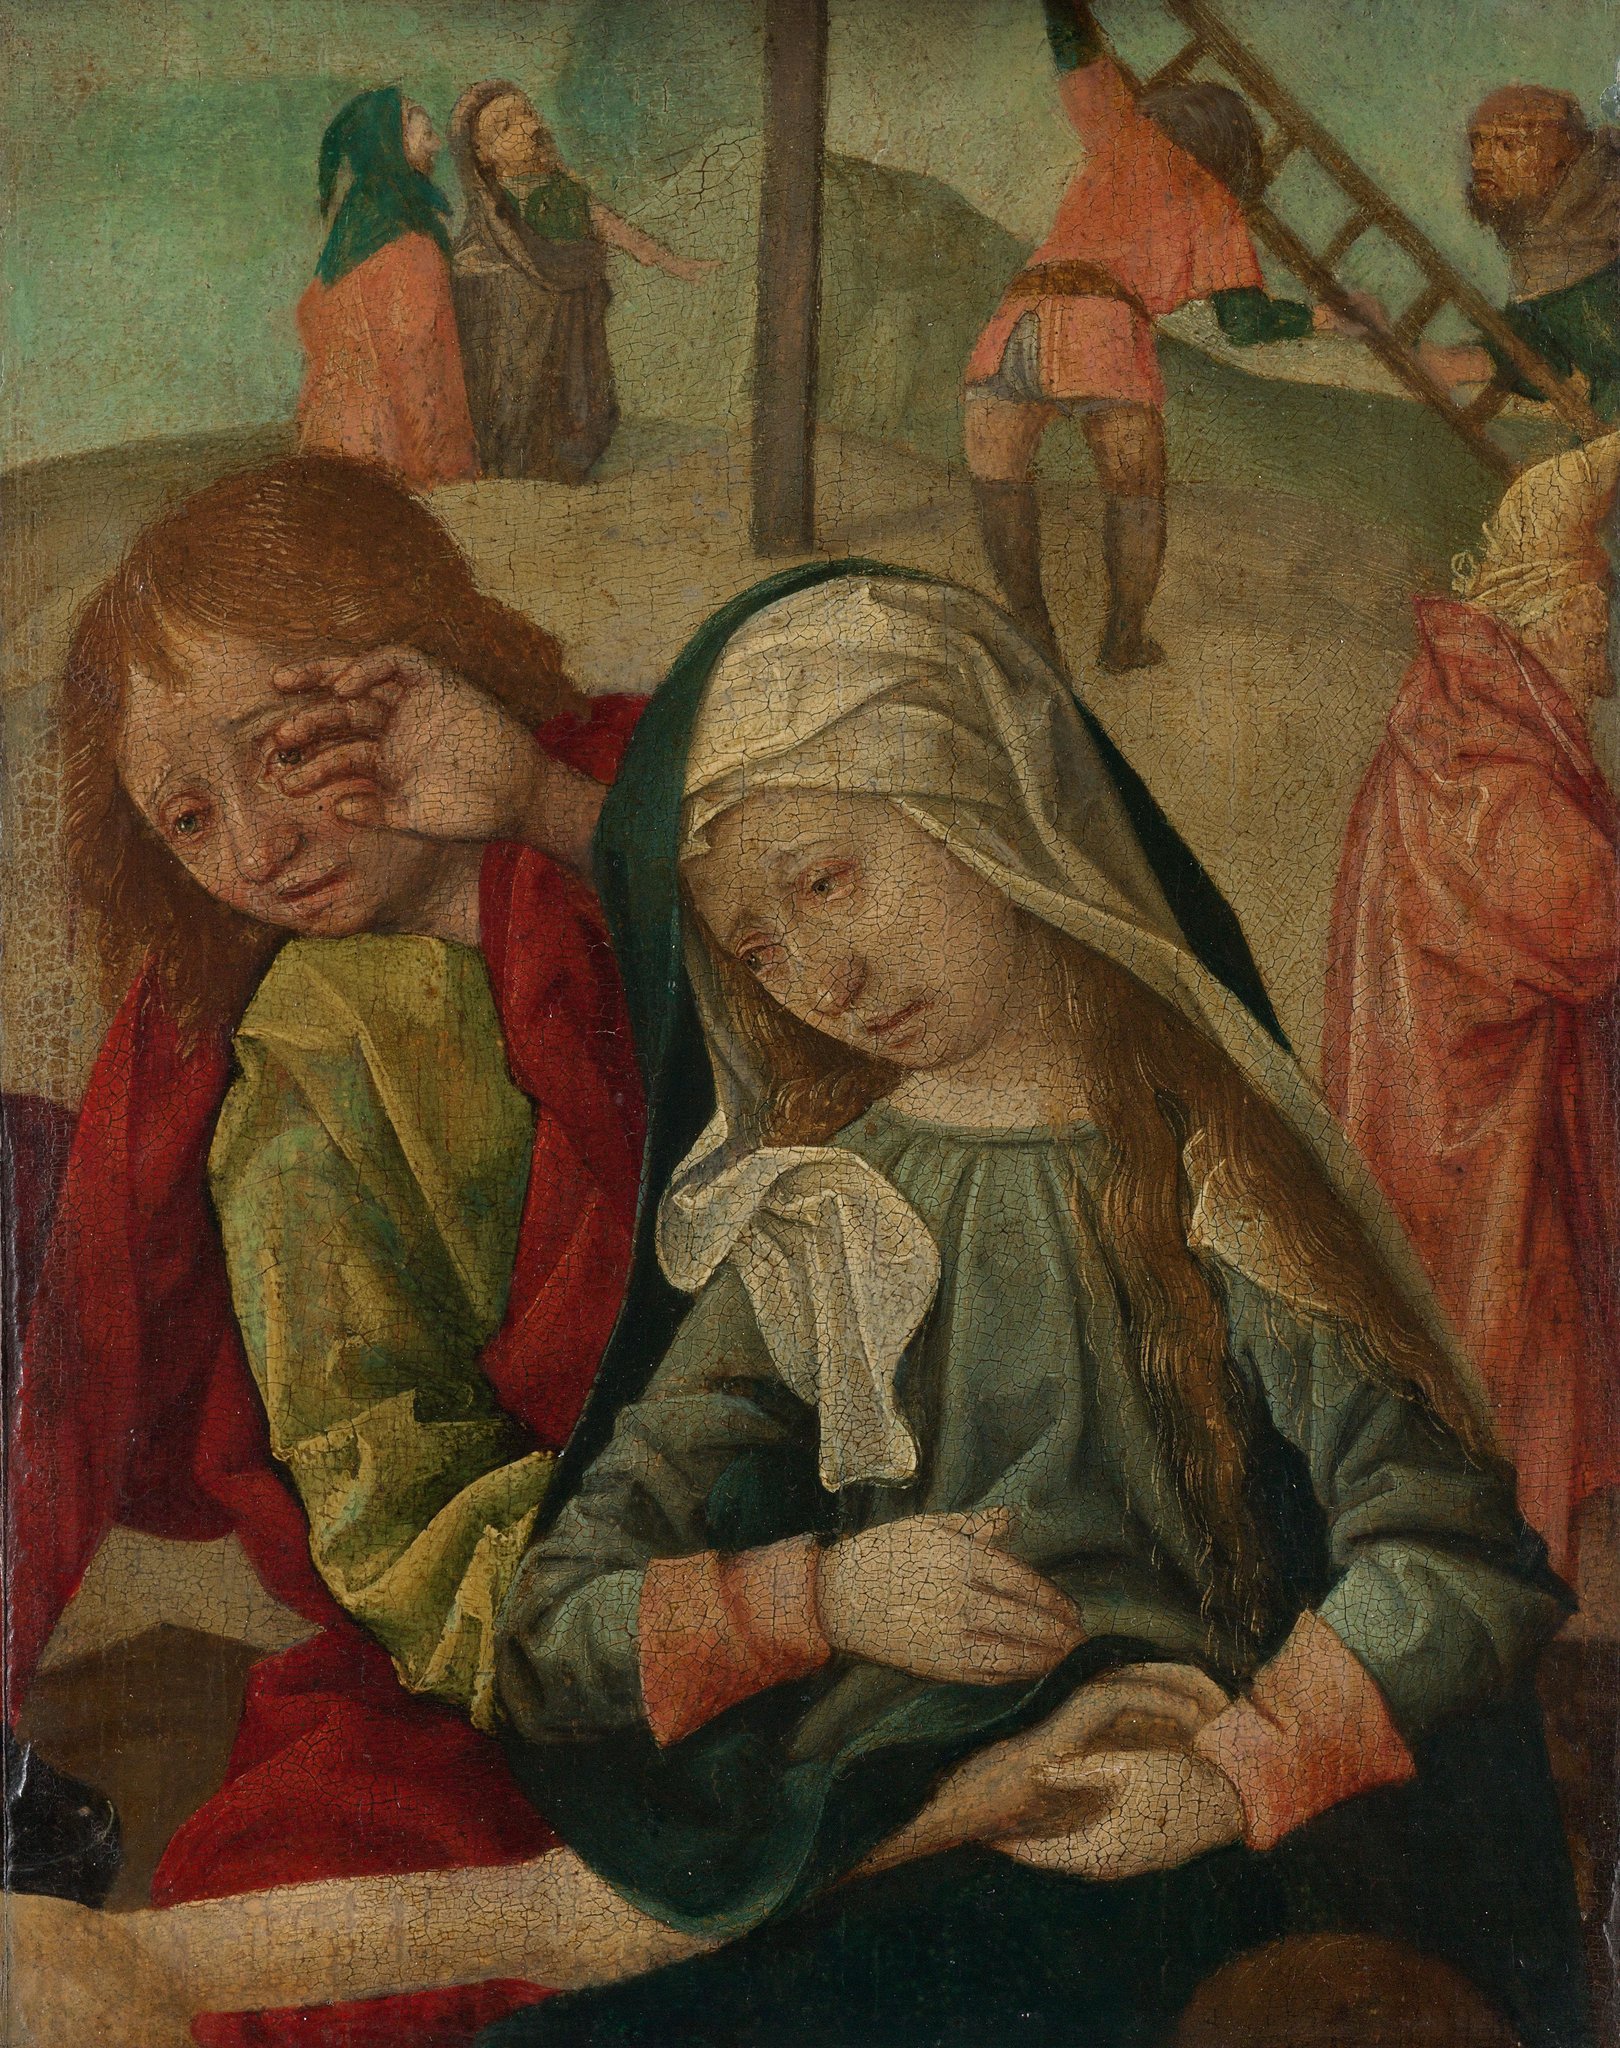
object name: fragment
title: Virgin and Saint John Mourning over the Body of Christ, fragment of a Lamentation of Christ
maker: master of delft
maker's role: painter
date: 1500-1510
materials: oil, panel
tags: lamentation over the dead christ by his relatives and friends (christ usually without crown of thorns)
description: Halffiguren van Maria en Johannes wenend bij het lichaam van Christus. Op de achtergrond is een deel van de kruisafneming te zien. Fragment van een grotere voorstelling van de Bewening.